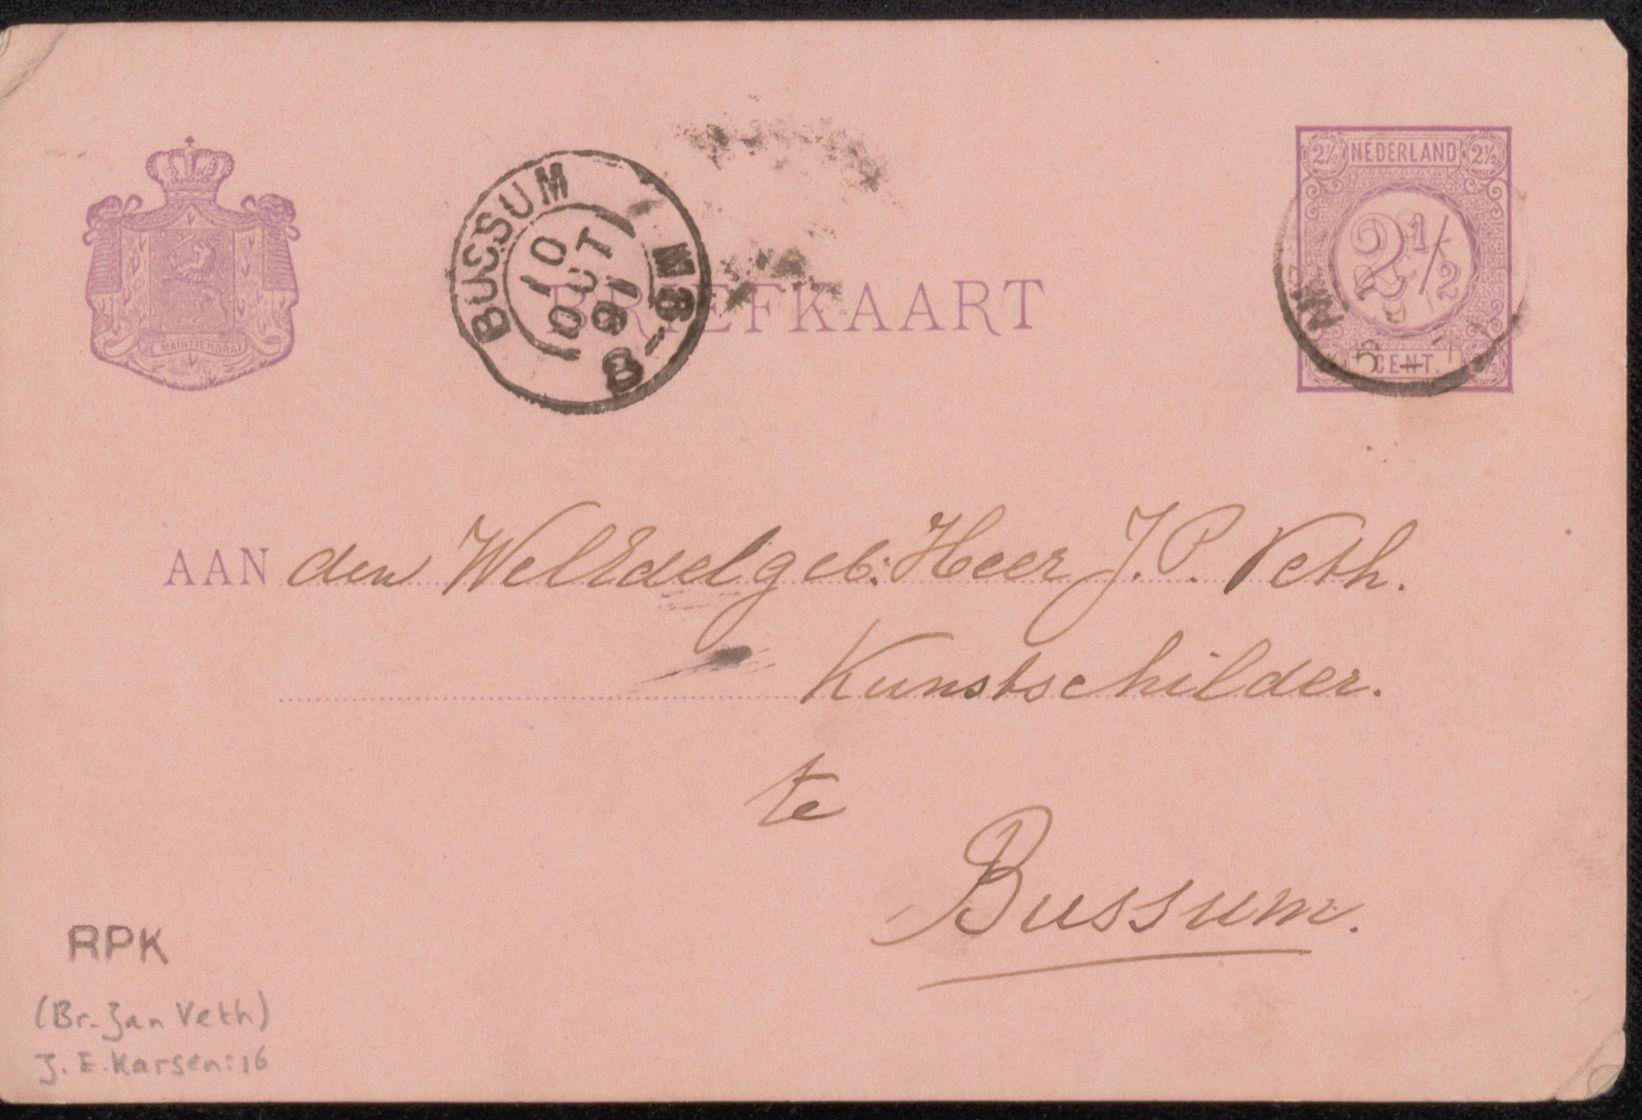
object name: postcard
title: Briefkaart aan Jan Veth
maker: eduard karsen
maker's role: draughtsman, painter, print maker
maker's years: 1860-1941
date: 1810-1891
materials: cardboard, ink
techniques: pen, writing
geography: amsterdam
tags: designer, jan veth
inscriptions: collector's mark: ‘RPK’